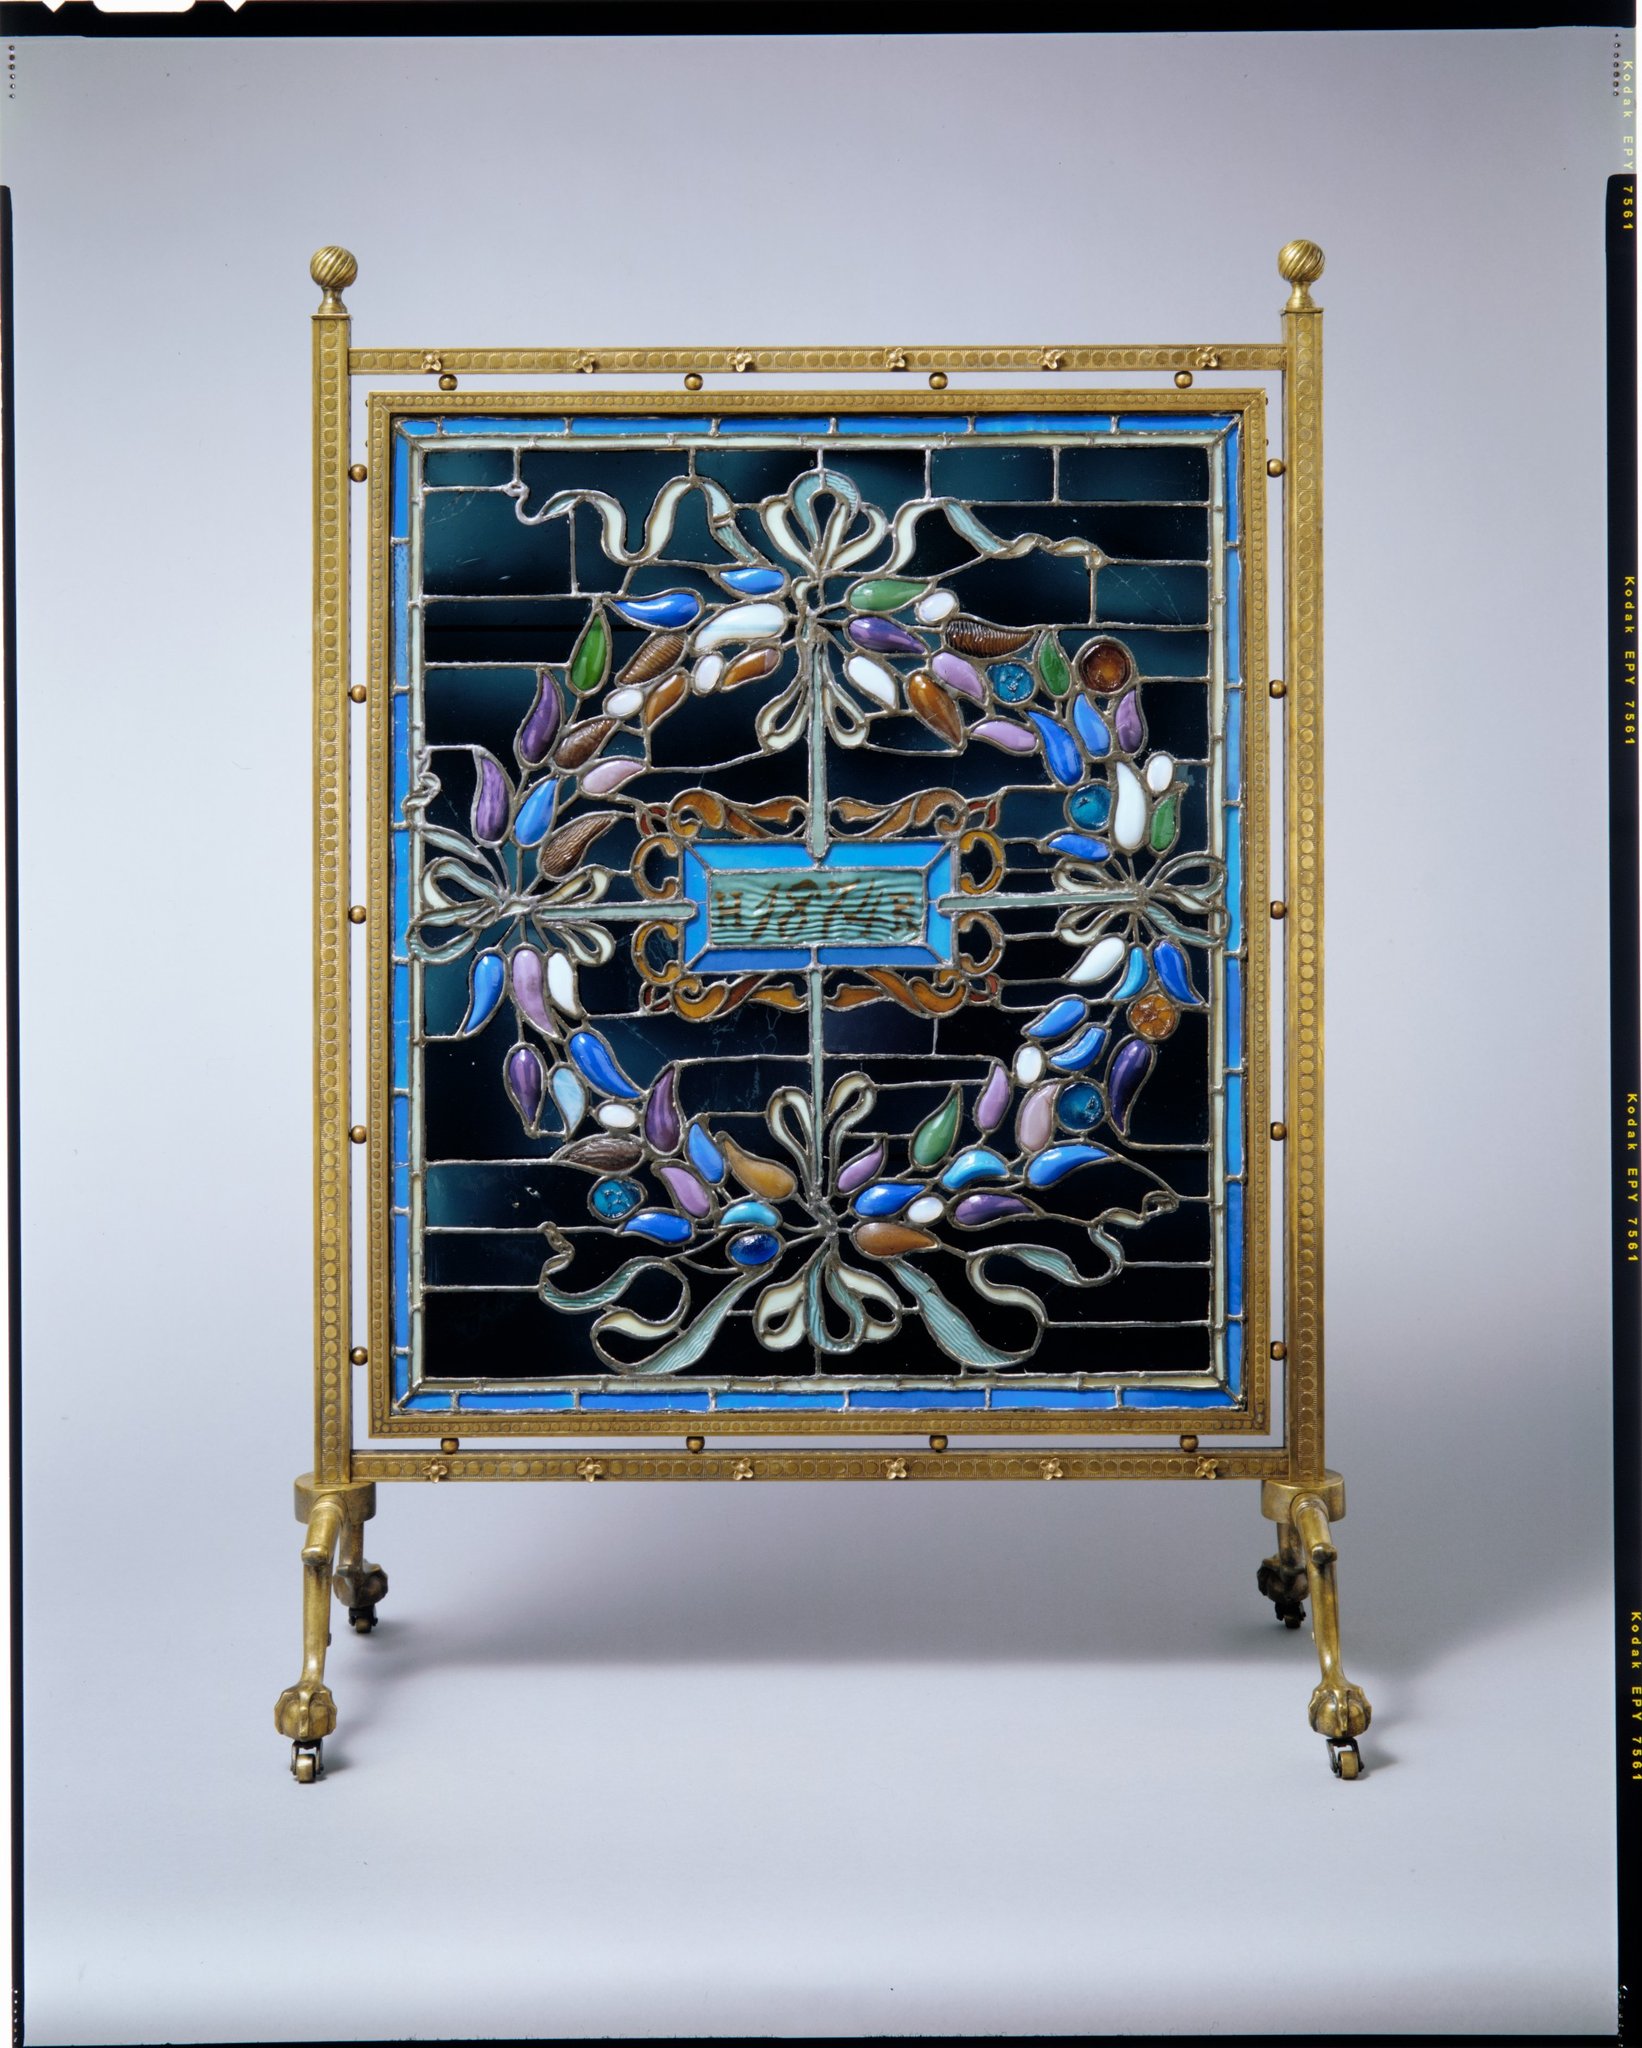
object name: firescreen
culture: american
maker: john la farge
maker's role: maker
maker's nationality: american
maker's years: 1835-1910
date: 1884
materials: brass, glass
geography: united states